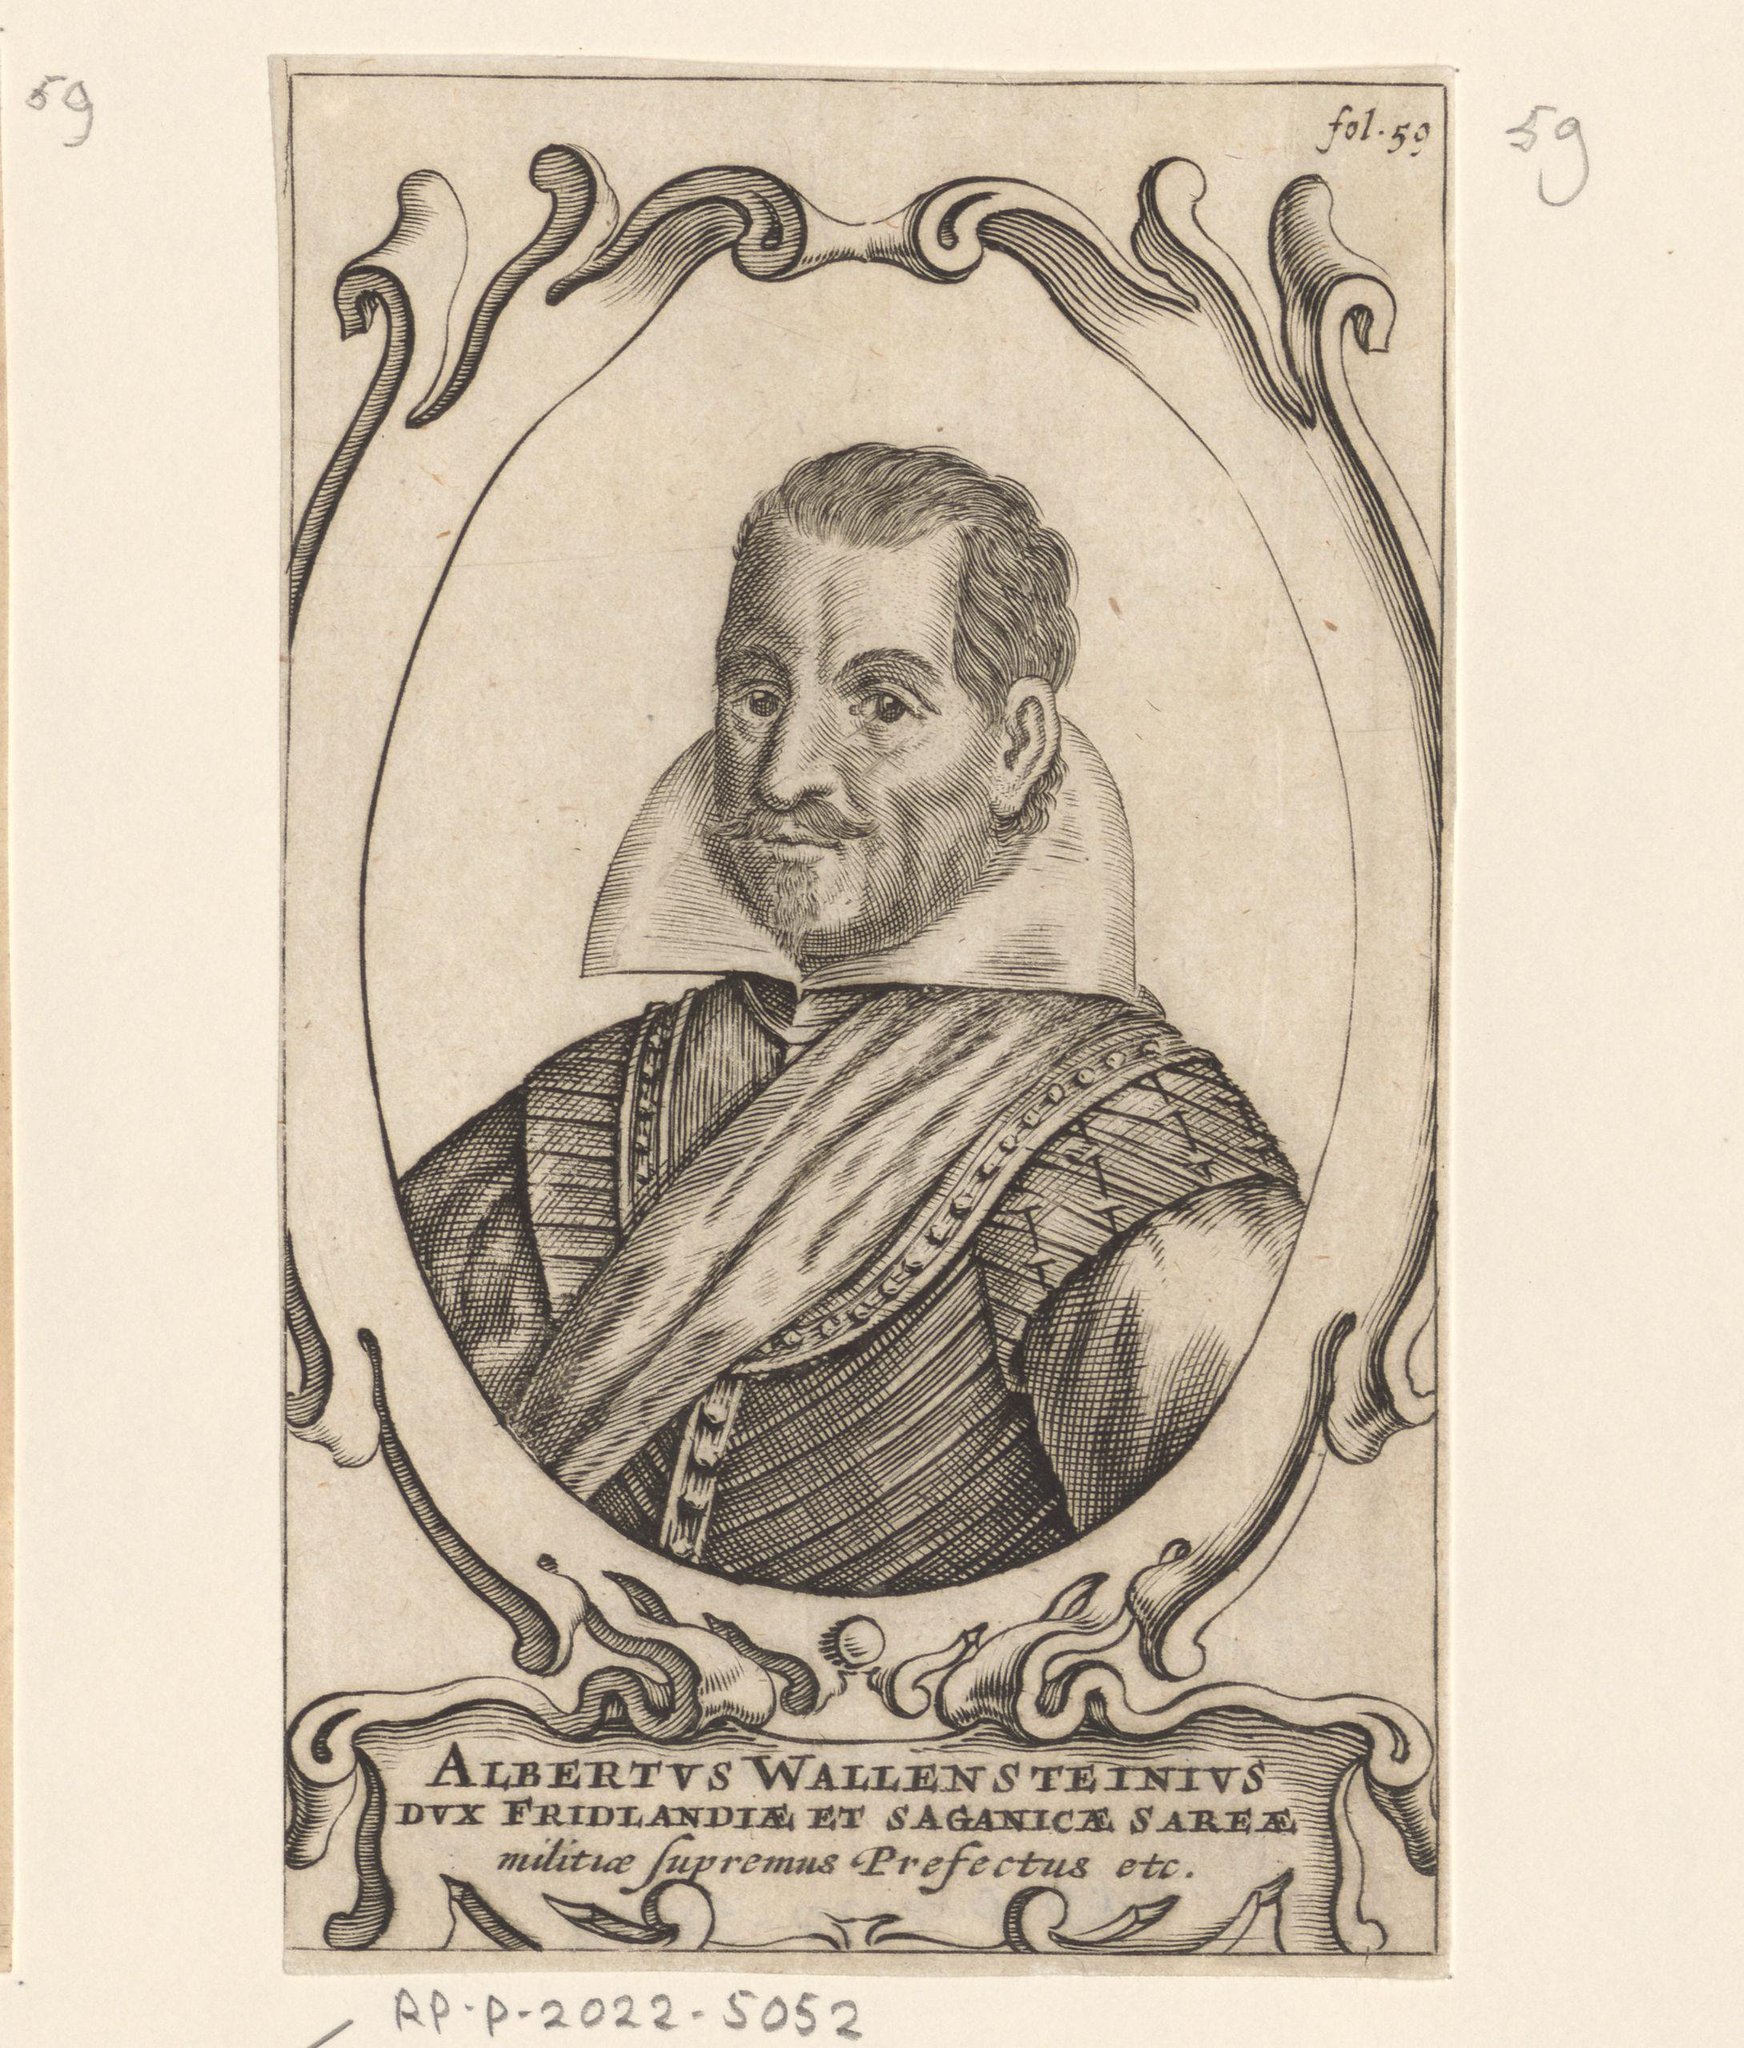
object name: book illustration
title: Portret van Albrecht von Wallenstein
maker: Anonymous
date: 1656-1666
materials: paper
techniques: engraving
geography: northern netherlands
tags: commander-in-chief, general, marshal, historical persons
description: Prent waarschijnlijk uit: Brachelius, Johannes Adolphus. Historia nostri temporis, dat is geschiedenis onses tijdts (…). Rotterdam: Andries van Hoogenhuysen, 1656. Prent ook gebruikt in de 1659- en 1666-editie.